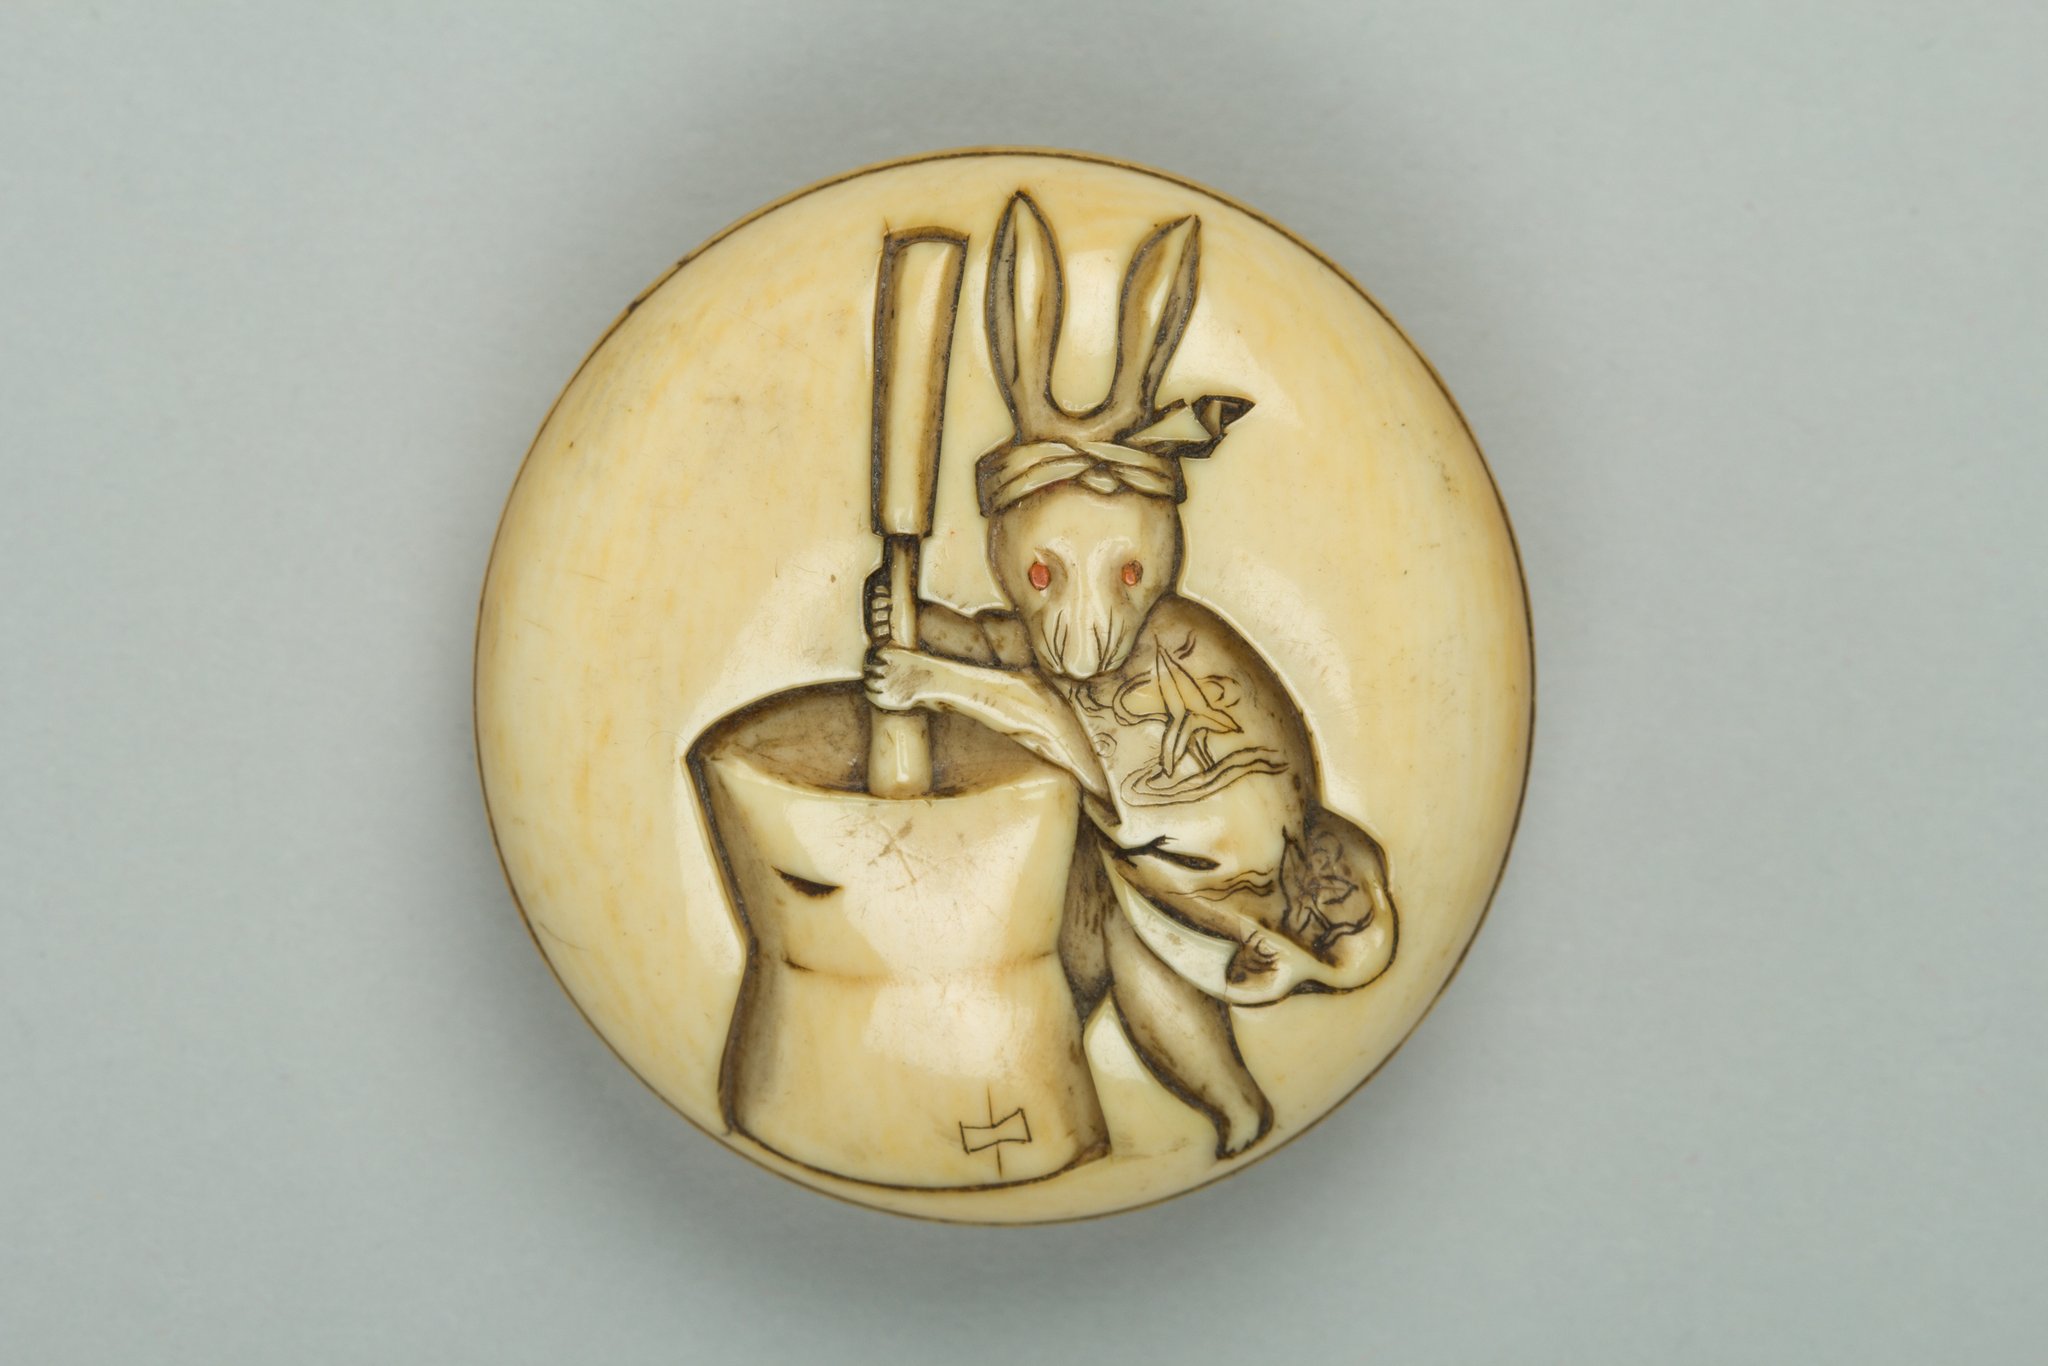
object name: netsuke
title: Netsuke of Rabbit Stirring Elixir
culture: japanese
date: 1801-1900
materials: ivory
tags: rabbits